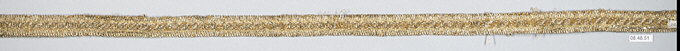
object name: galloon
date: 1580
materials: metal thread